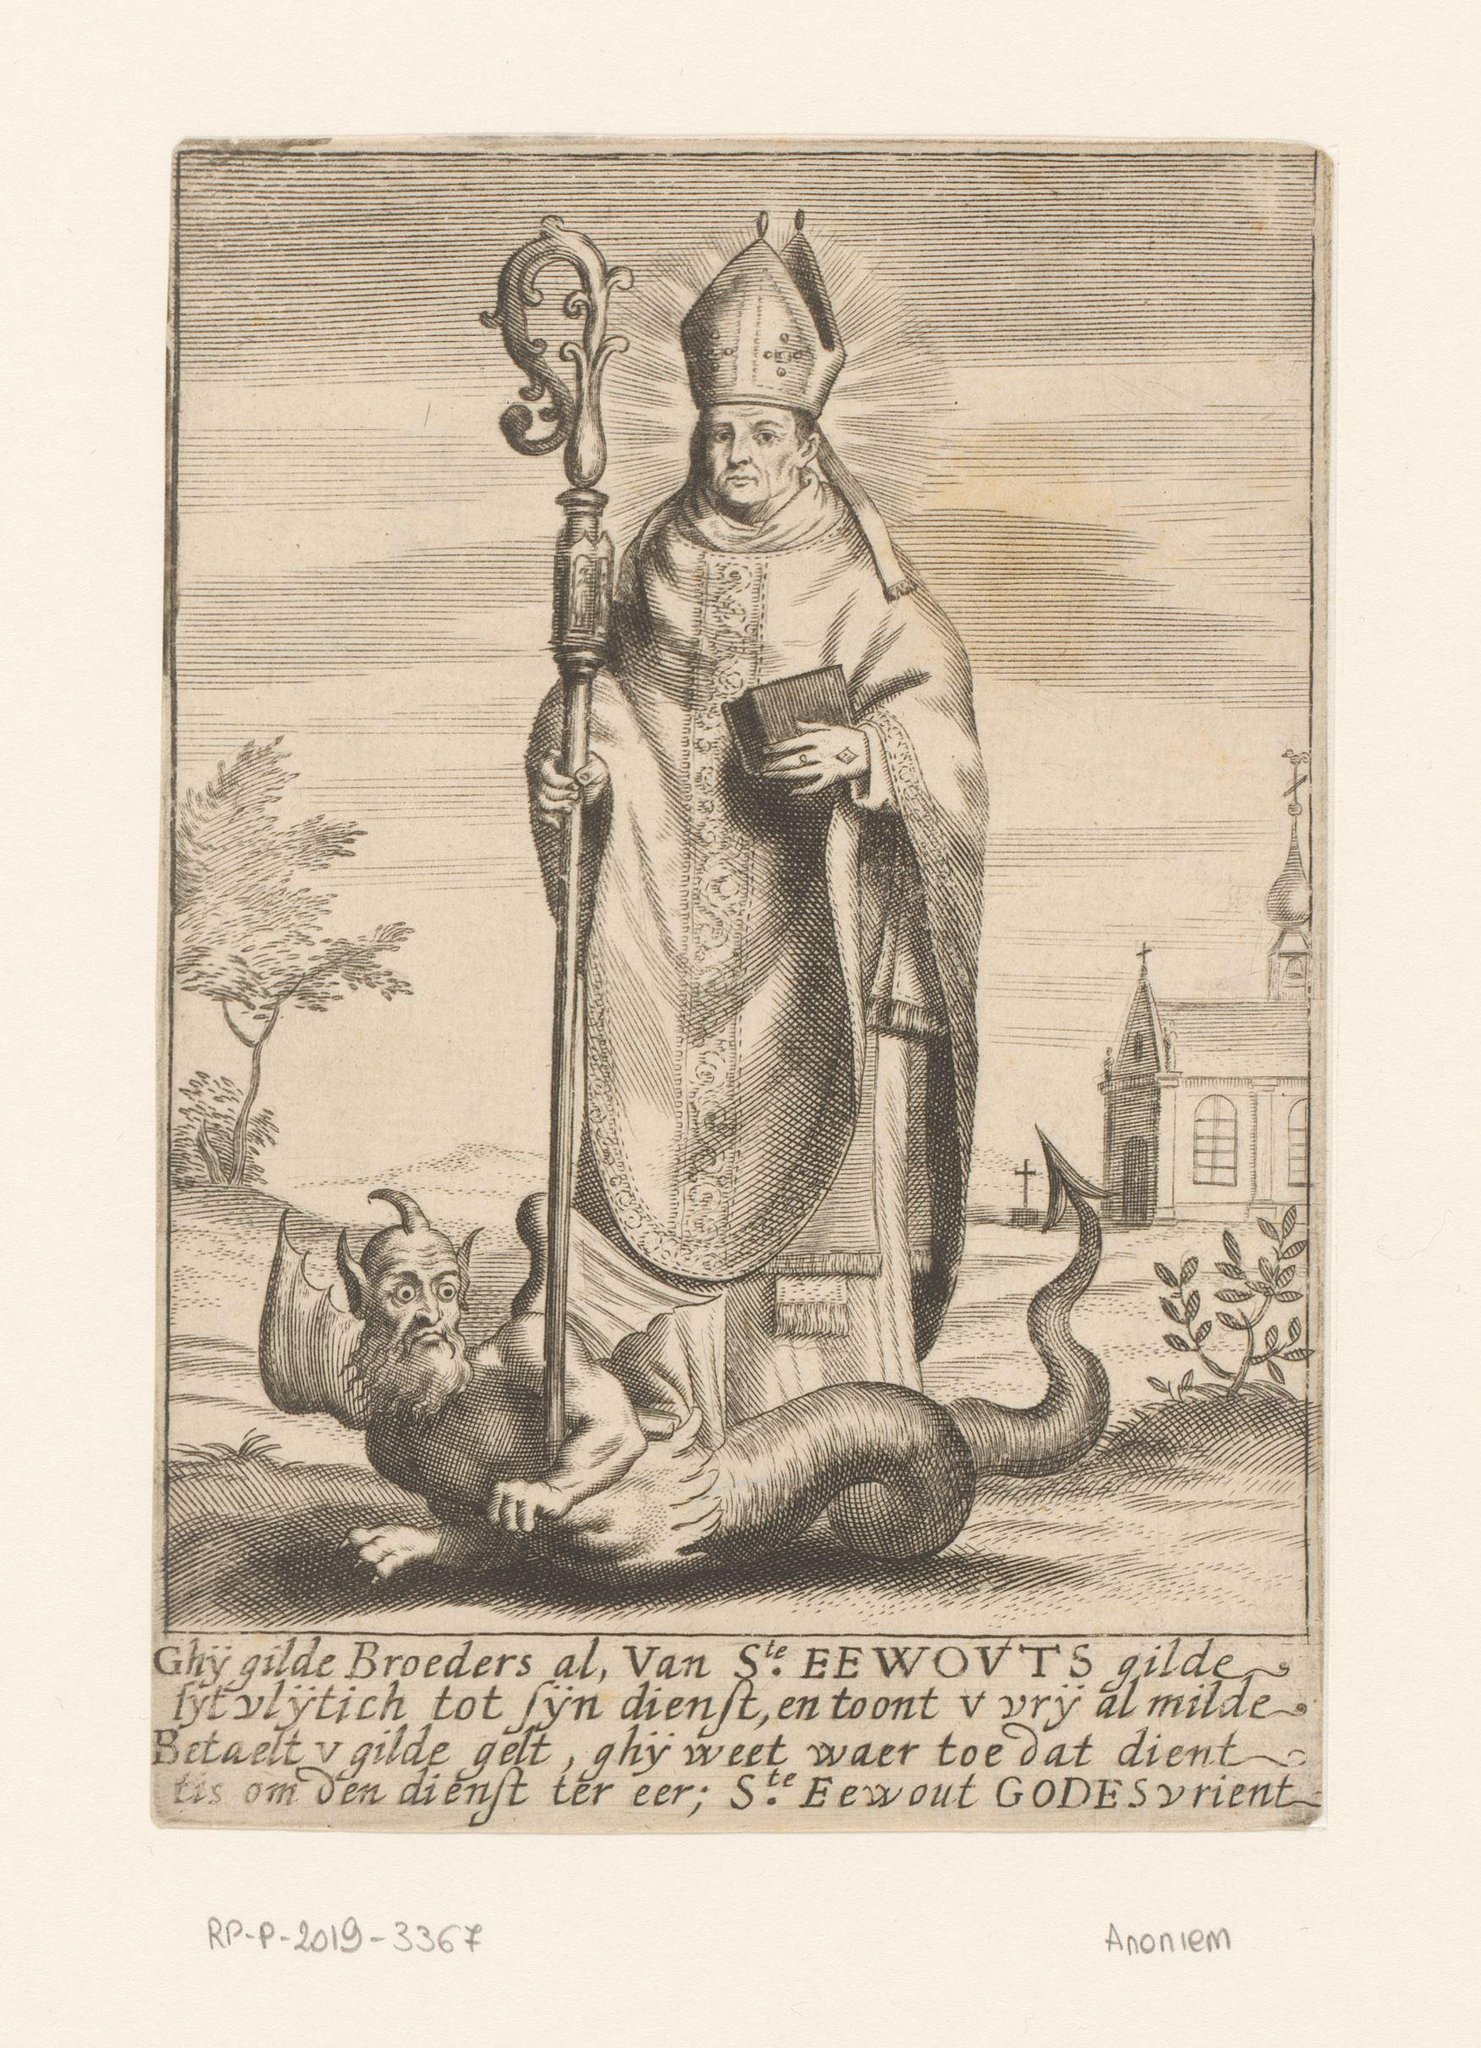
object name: print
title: Gildeprent van het Sint Ewoutsgilde met de H. Ewout een duivel vertrappend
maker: Anonymous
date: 1600-1699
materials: paper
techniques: engraving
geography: netherlands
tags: insignia of a guild, saints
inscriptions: collector's mark: Lugt 2228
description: Mogelijk betreft dit een prent van het Kuipers- of Sint-Ewoutsgilde.